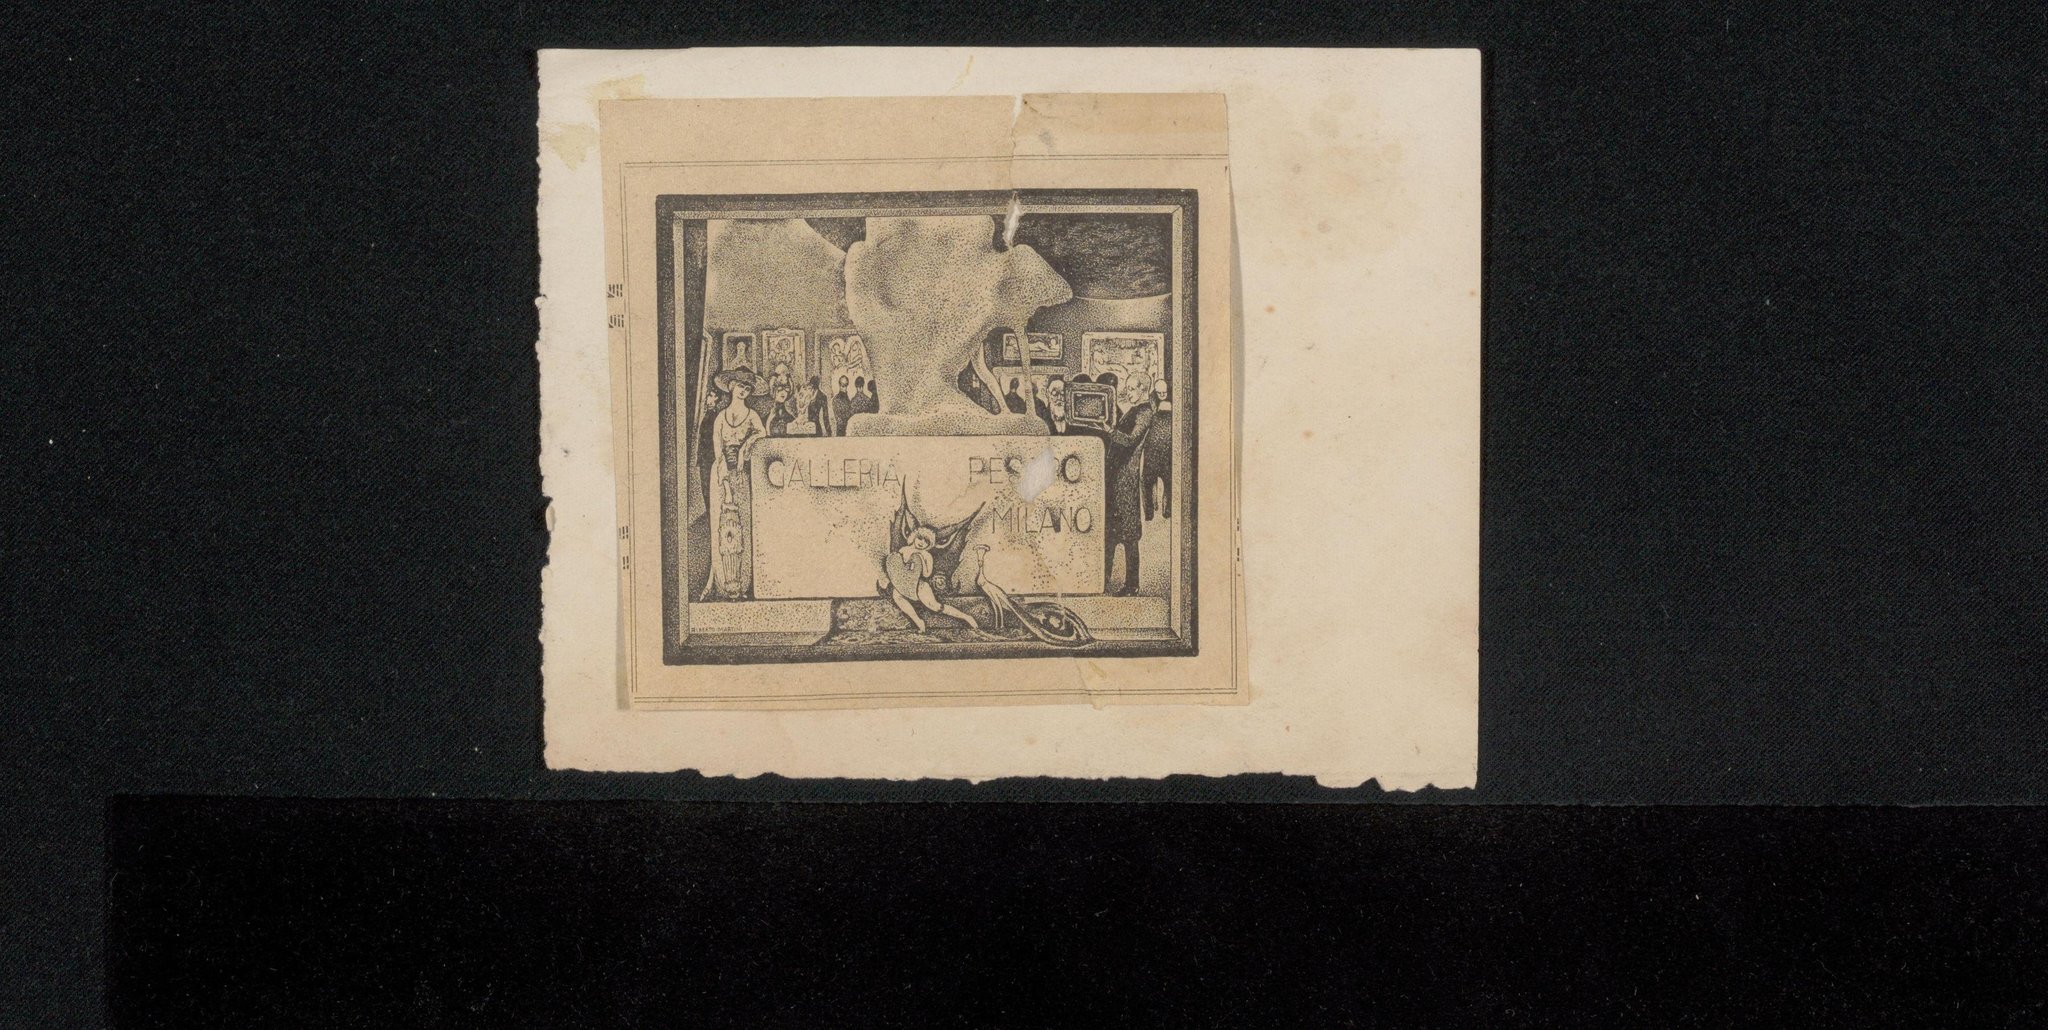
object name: print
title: Prent uit archief Philip Zilcken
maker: Anonymous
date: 1867-1930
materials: ink, paper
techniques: photochemical processes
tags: the hague, painter, draughtsman, philip zilcken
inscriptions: collector's mark: ‘RPK’